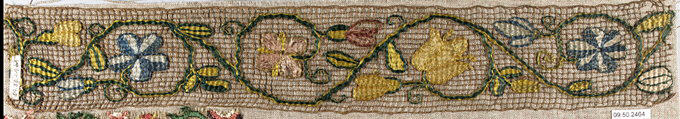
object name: strip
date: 1601-1700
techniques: embroidery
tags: flowers